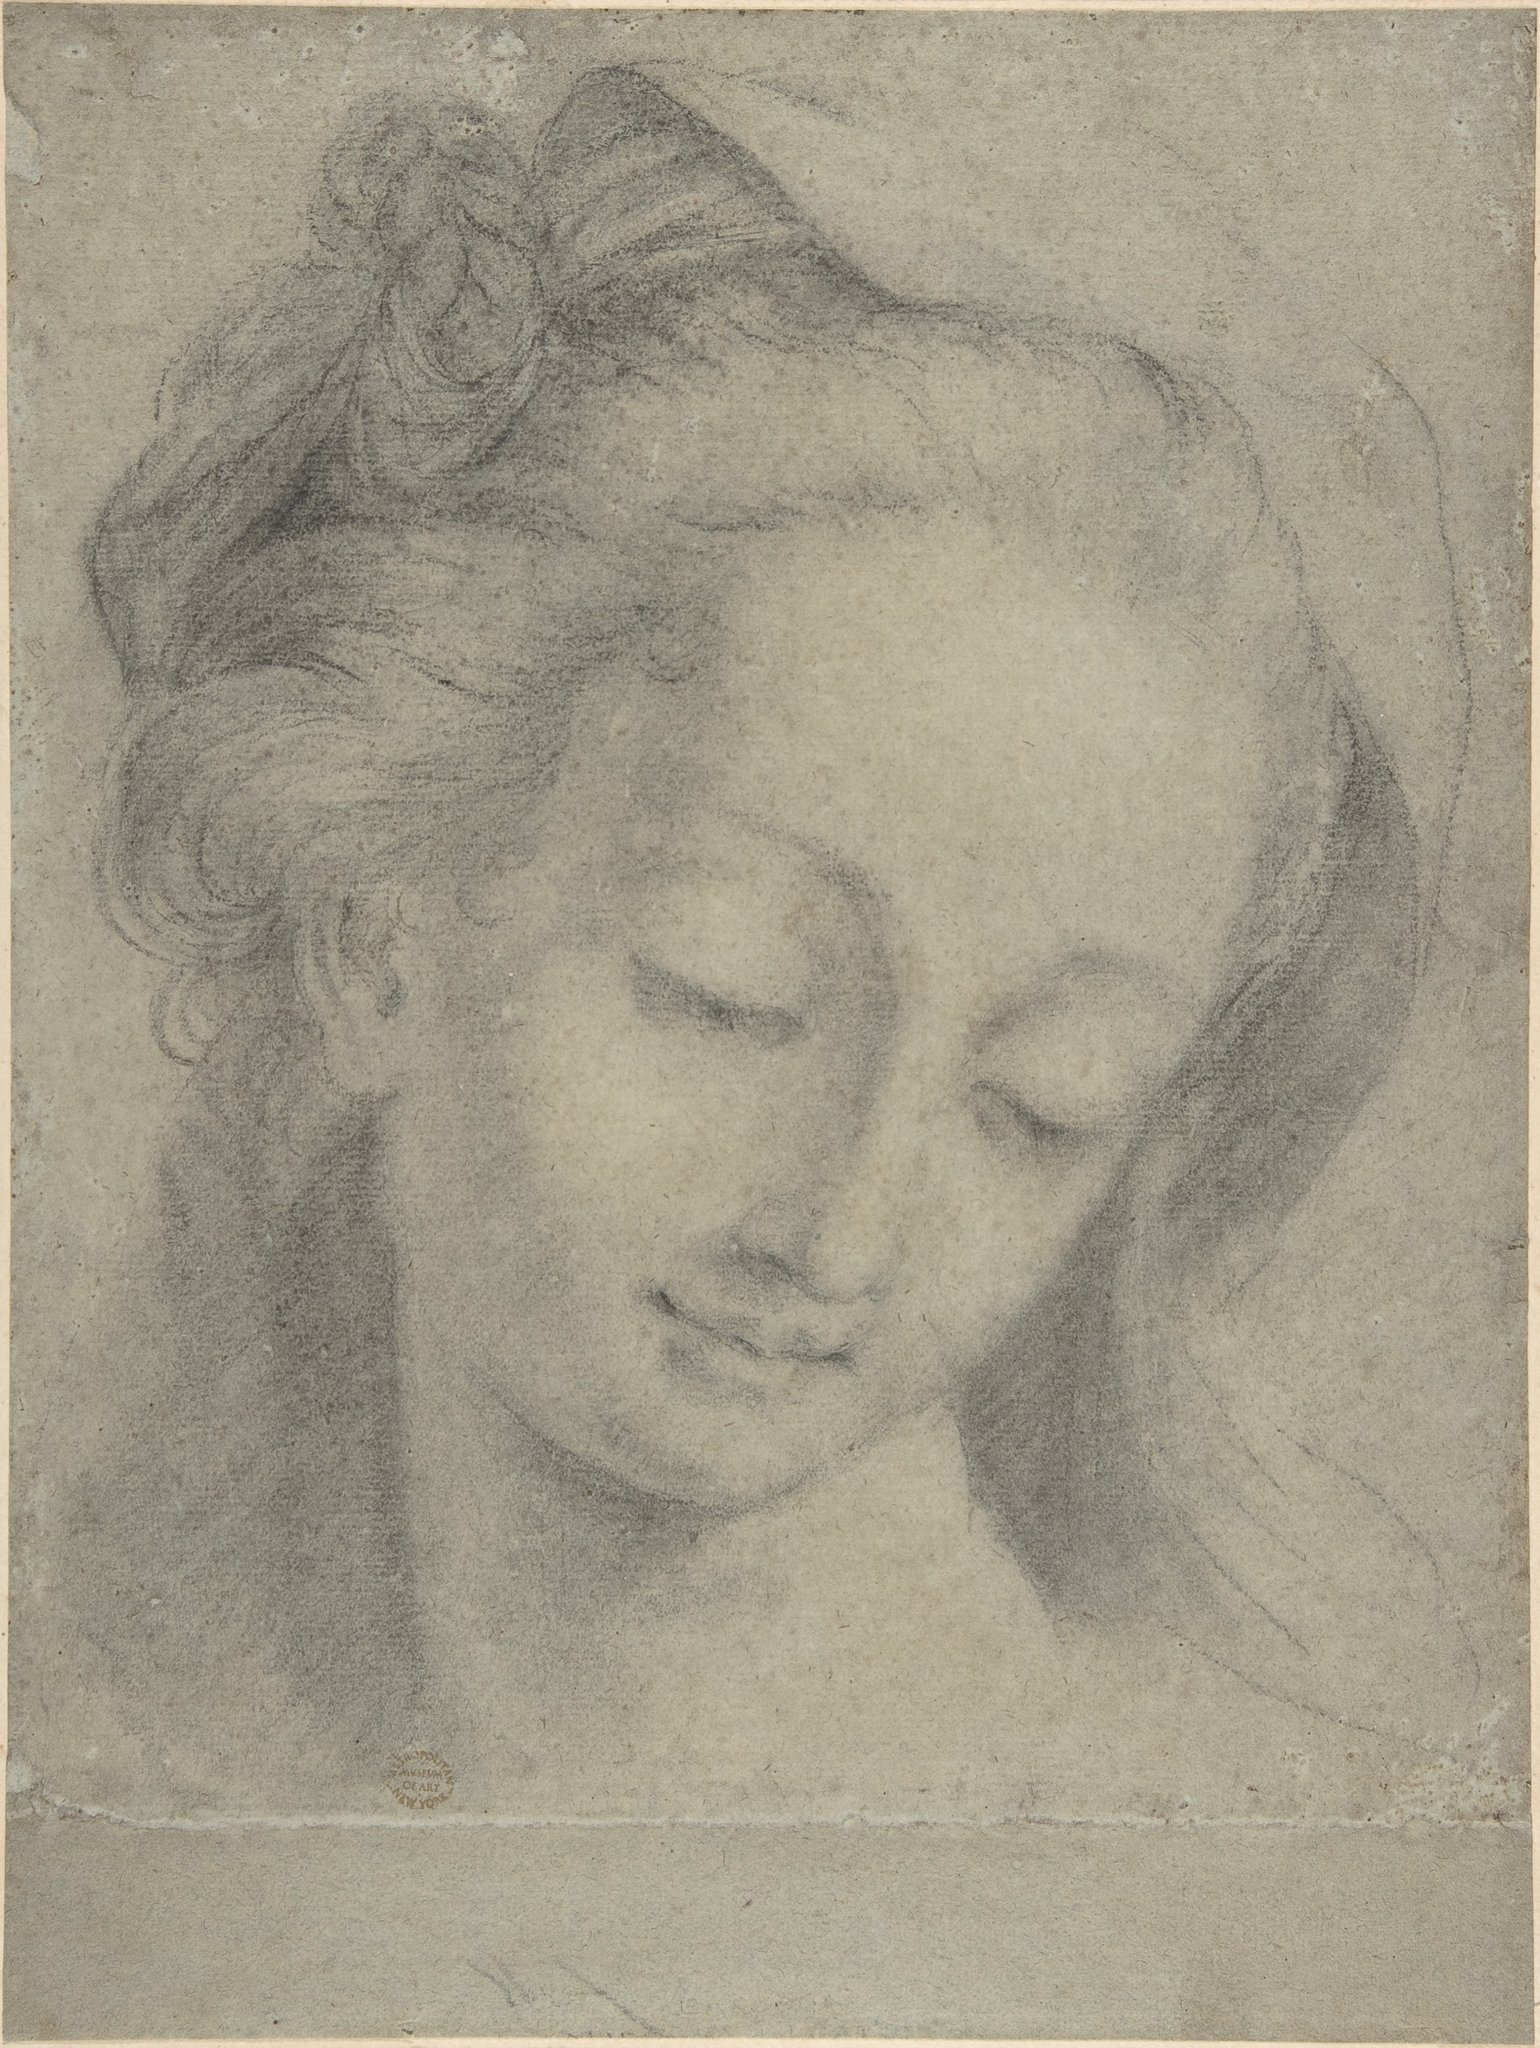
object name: drawing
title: Head of a Woman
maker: anonymous, french, 17th century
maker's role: artist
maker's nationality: french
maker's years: 1600-1700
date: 1651-1700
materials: chalk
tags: heads,portraits,women